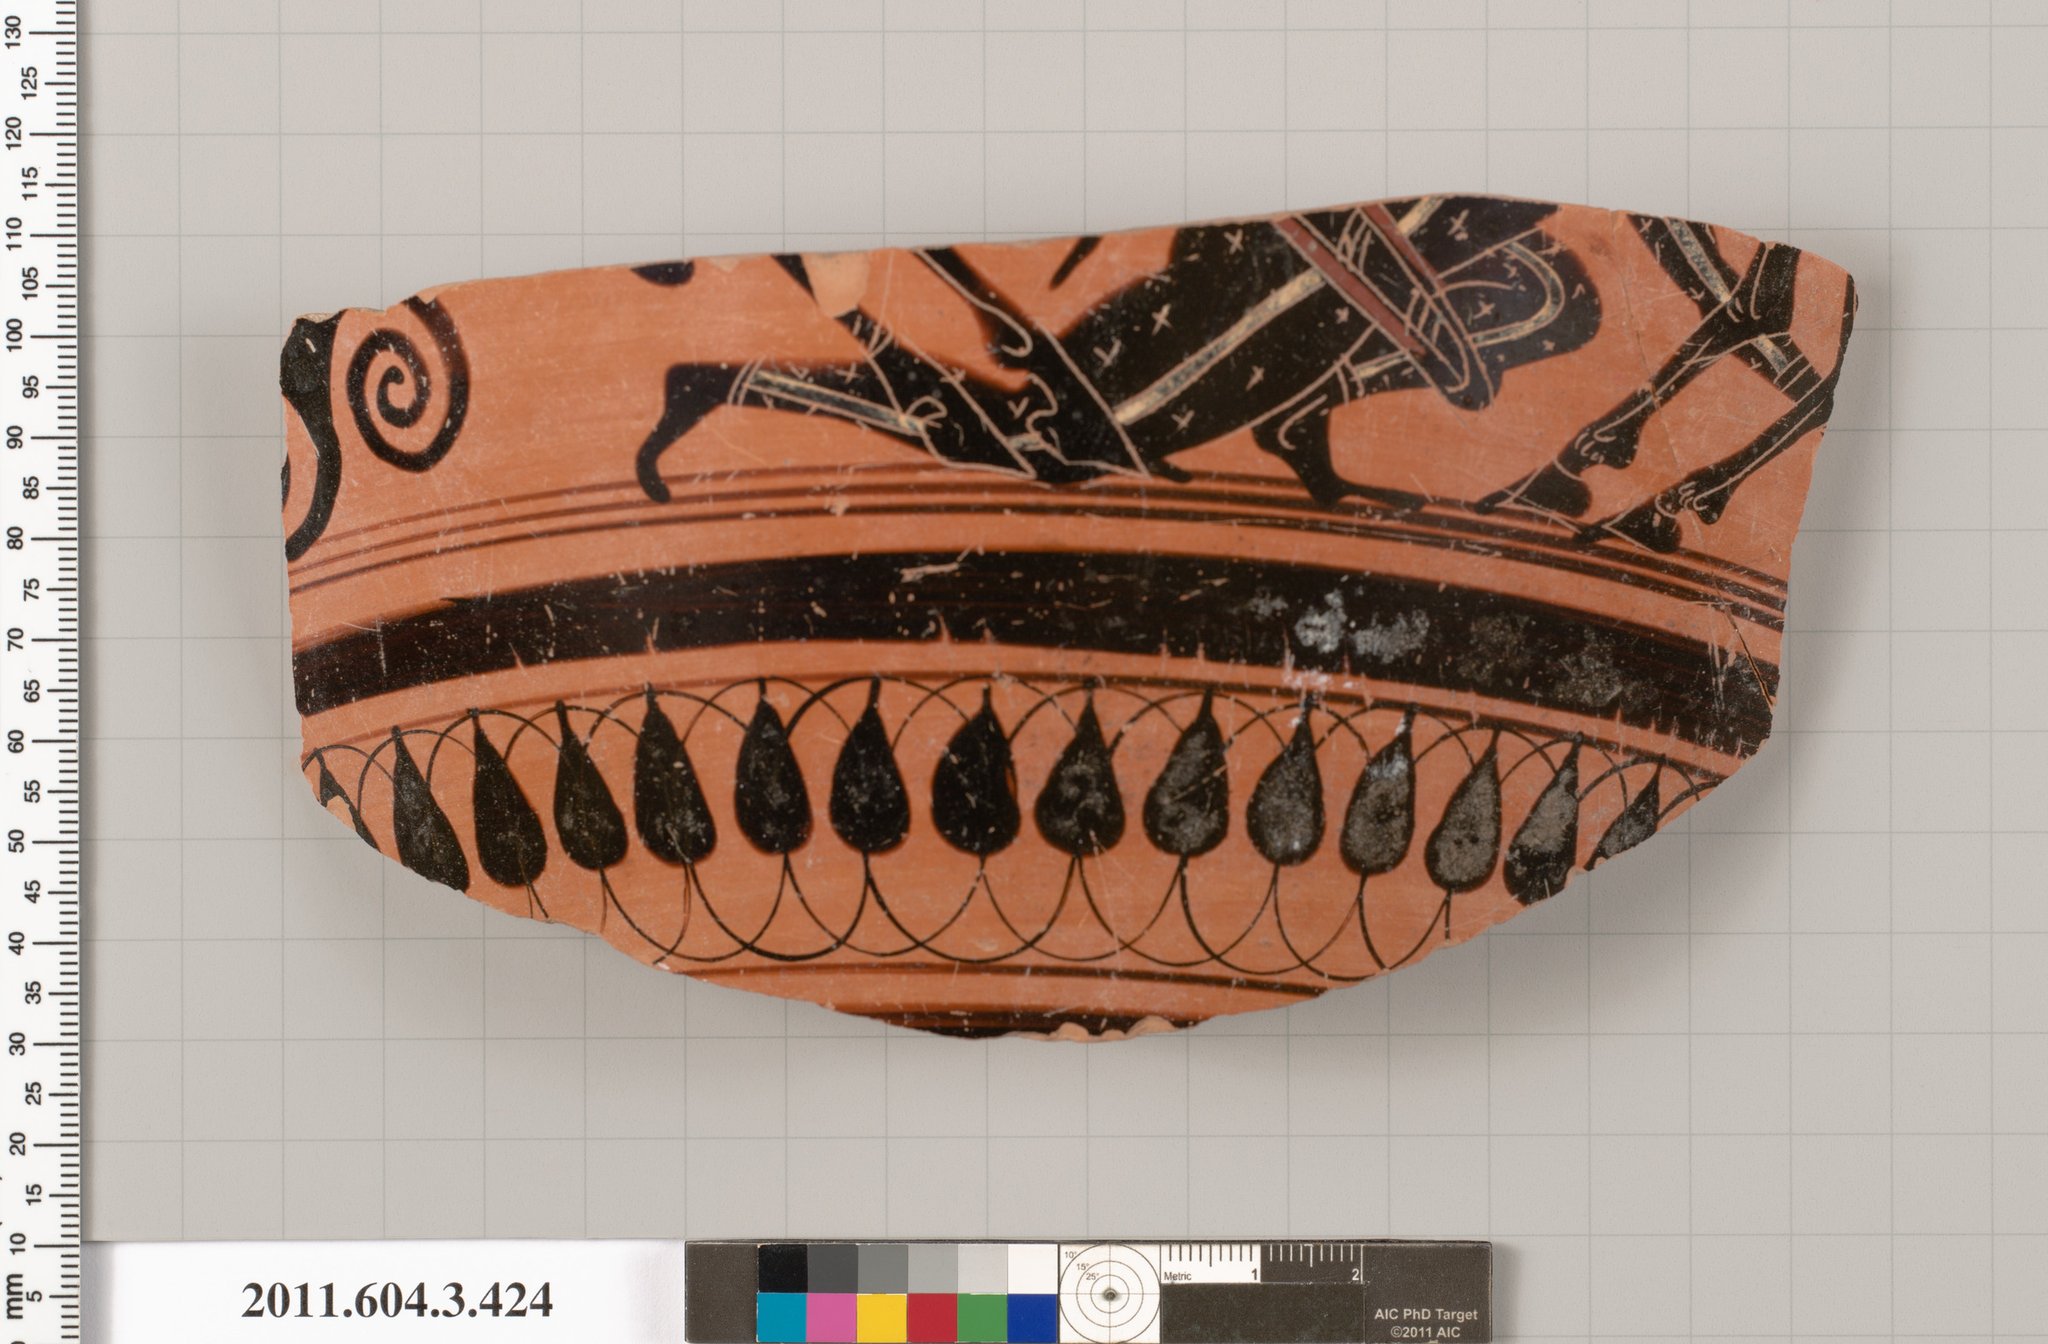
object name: neck amphora fragment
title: Terracotta fragment of a neck-amphora (jar)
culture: greek, attic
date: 520-510 BCE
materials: terracotta